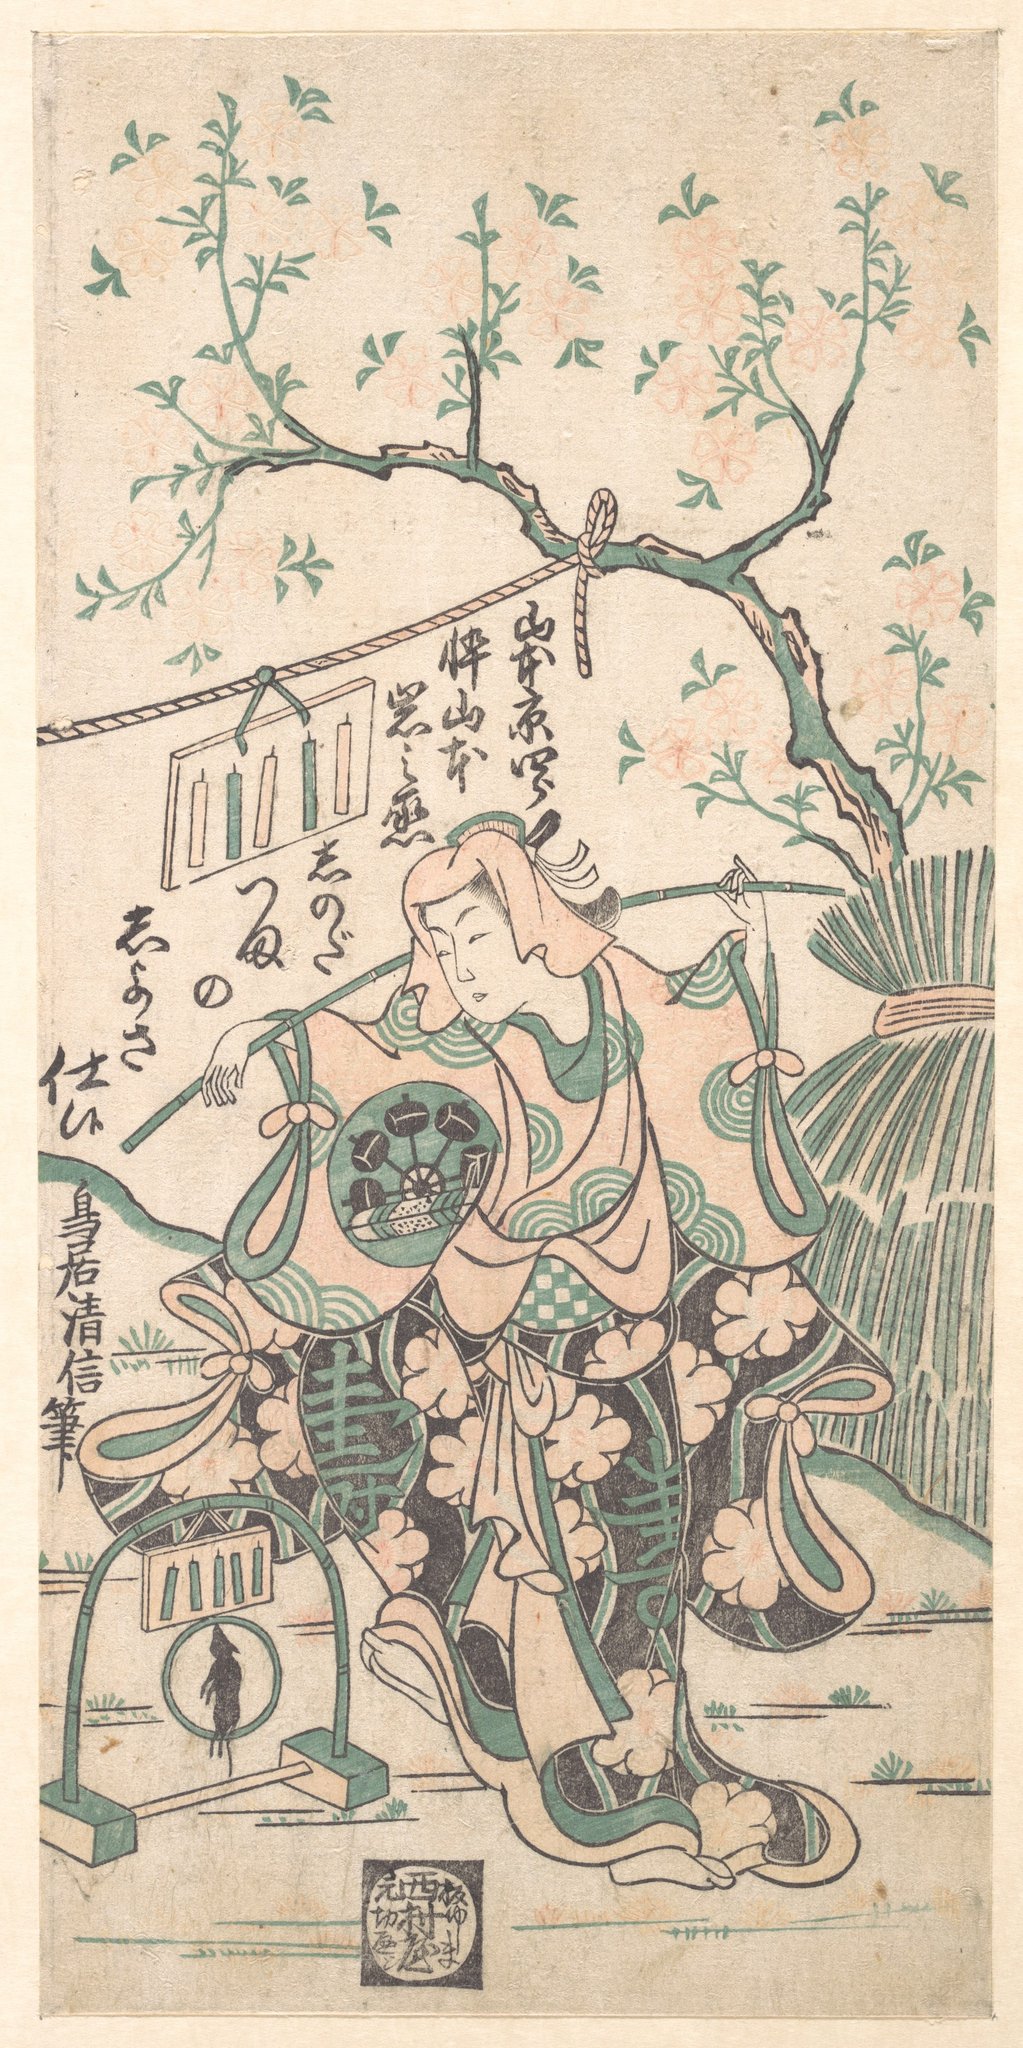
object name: print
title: Yamamoto Iwanojō, Son of Yamamoto Kyōshirō, as Shinoda Zuma in a Shosa Act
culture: japanese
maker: torii kiyonobu ii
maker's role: artist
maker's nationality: japanese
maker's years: 1702-1752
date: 1747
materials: ink, paper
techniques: woodblock print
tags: men,women,trees